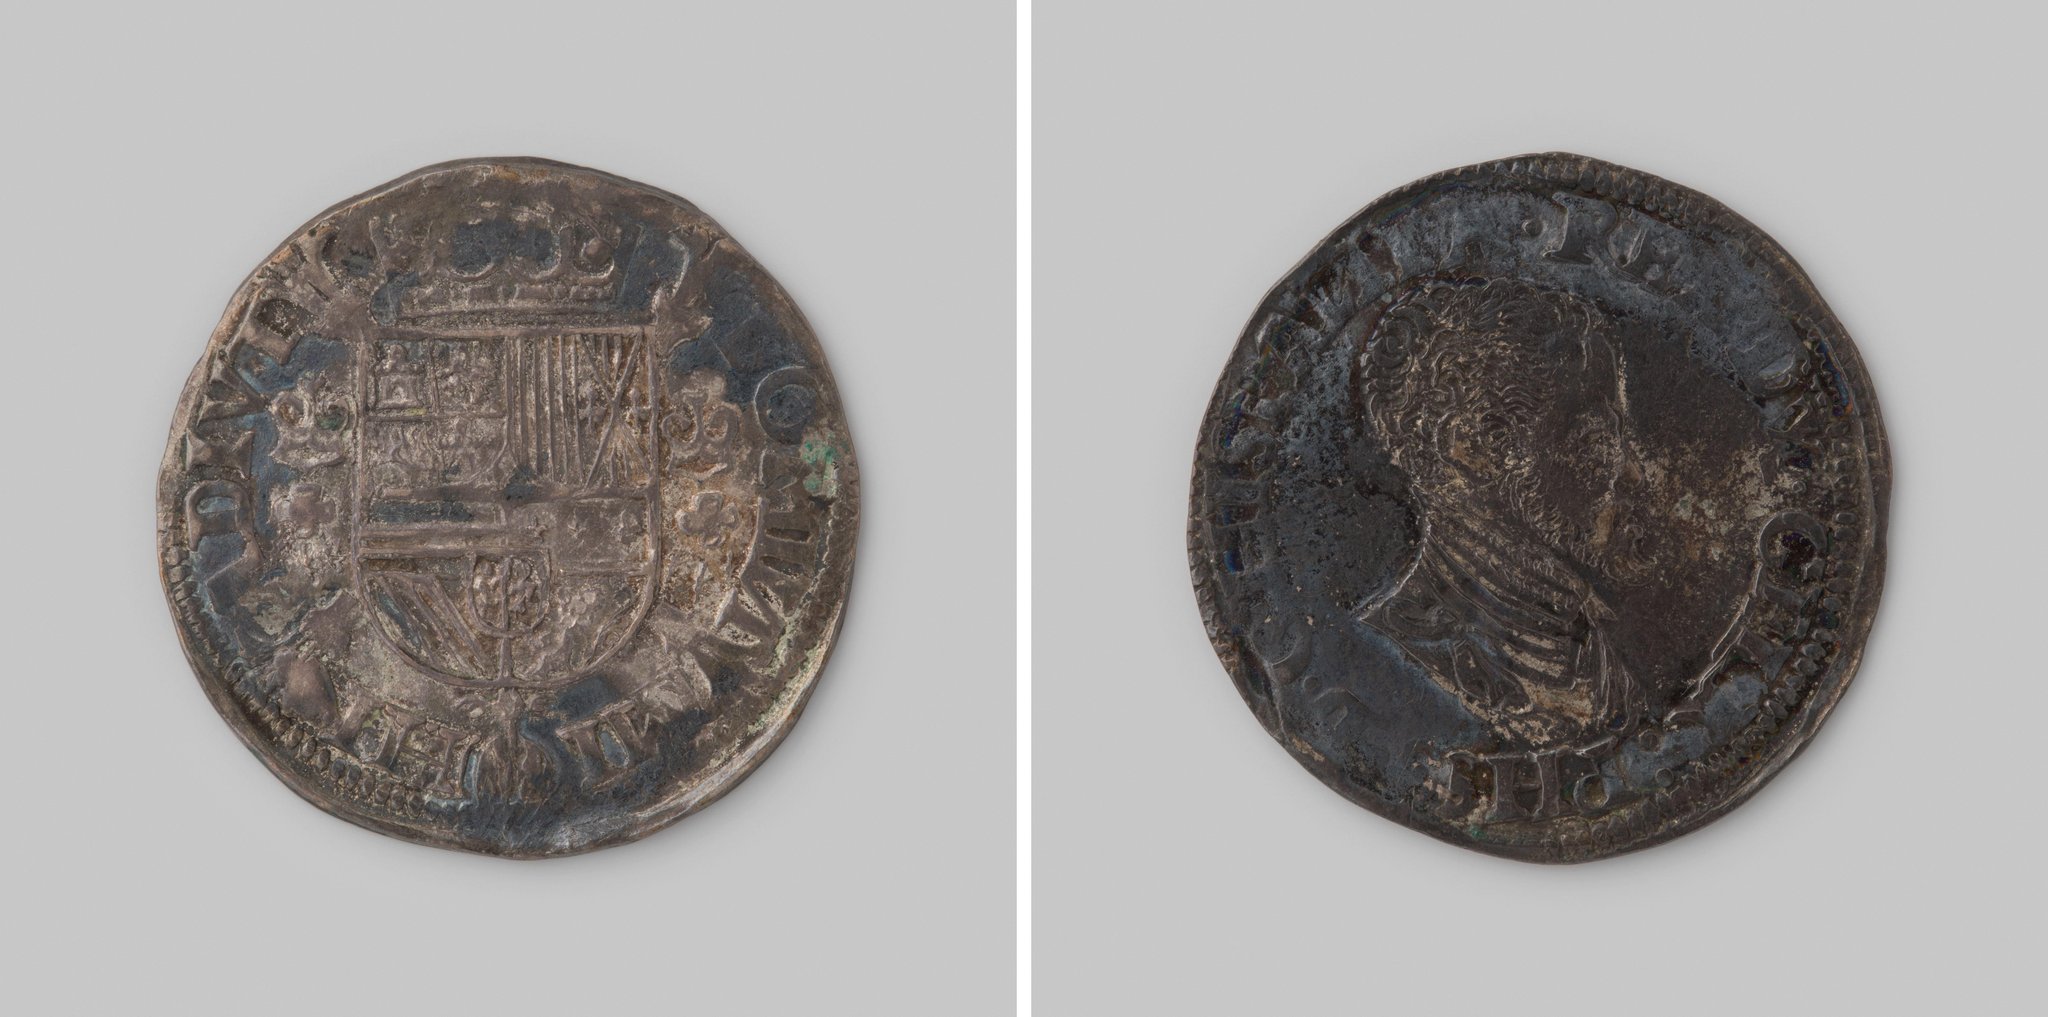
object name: coin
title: Gelderland, Philips II, vijfde philipsdaalder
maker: philip ii of spain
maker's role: koning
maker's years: 1527-1598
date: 1555-1598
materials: silver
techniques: striking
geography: gelderland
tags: philip ii of spain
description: Zilveren munt. Voorzijde: tussen twee vuurstenen gekroond Spaans-Bourgondisch wapenschild op stokkenkruis. Keerzijde: portret Philips II naar rechts.